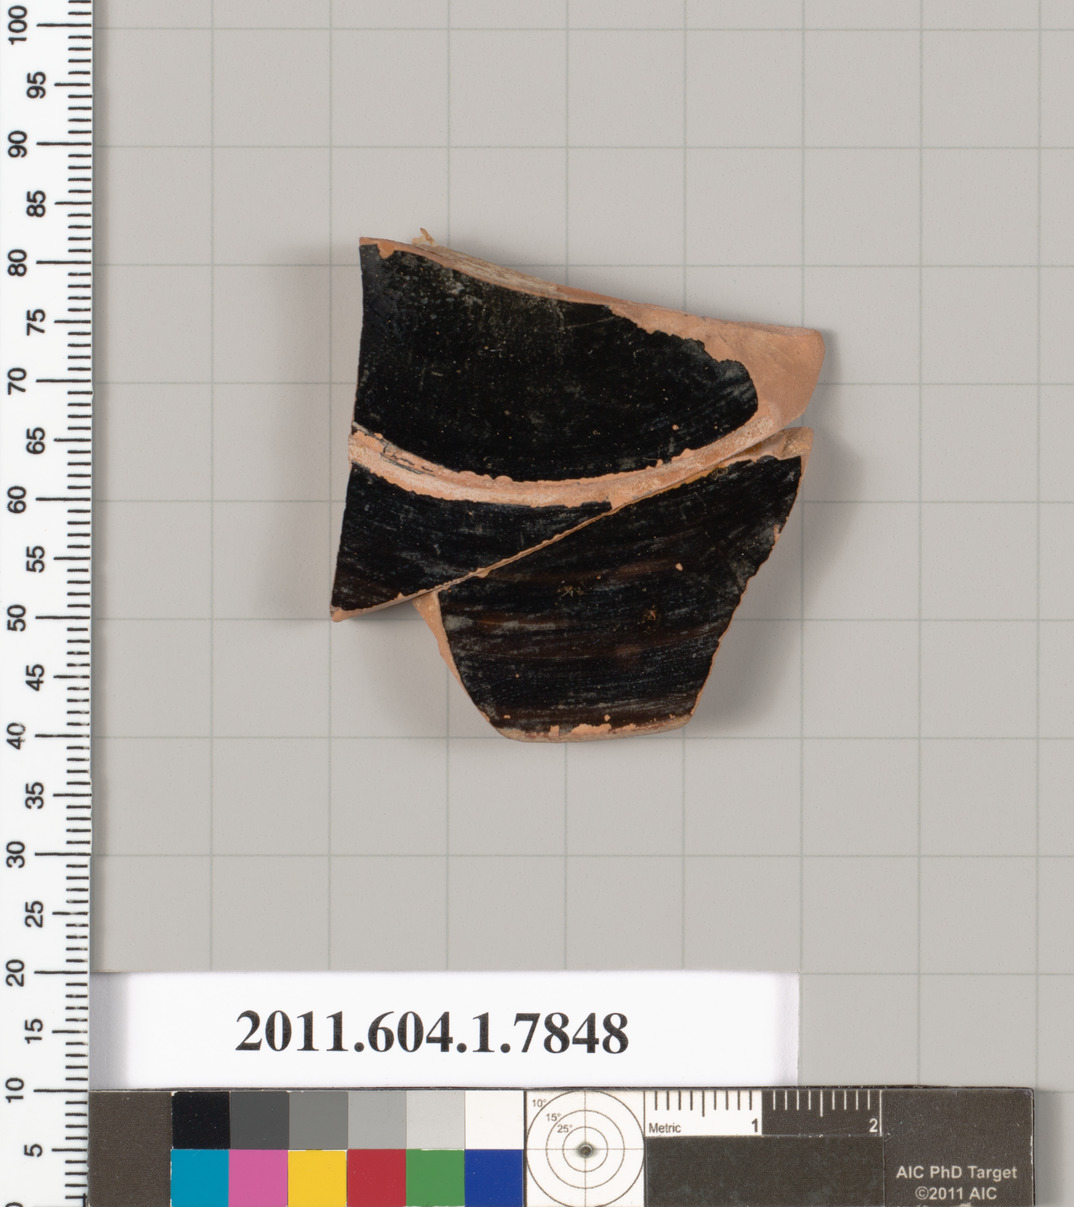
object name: kylix fragment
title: Terracotta fragment of a kylix (drinking cup)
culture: greek, attic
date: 460-450 BCE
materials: terracotta